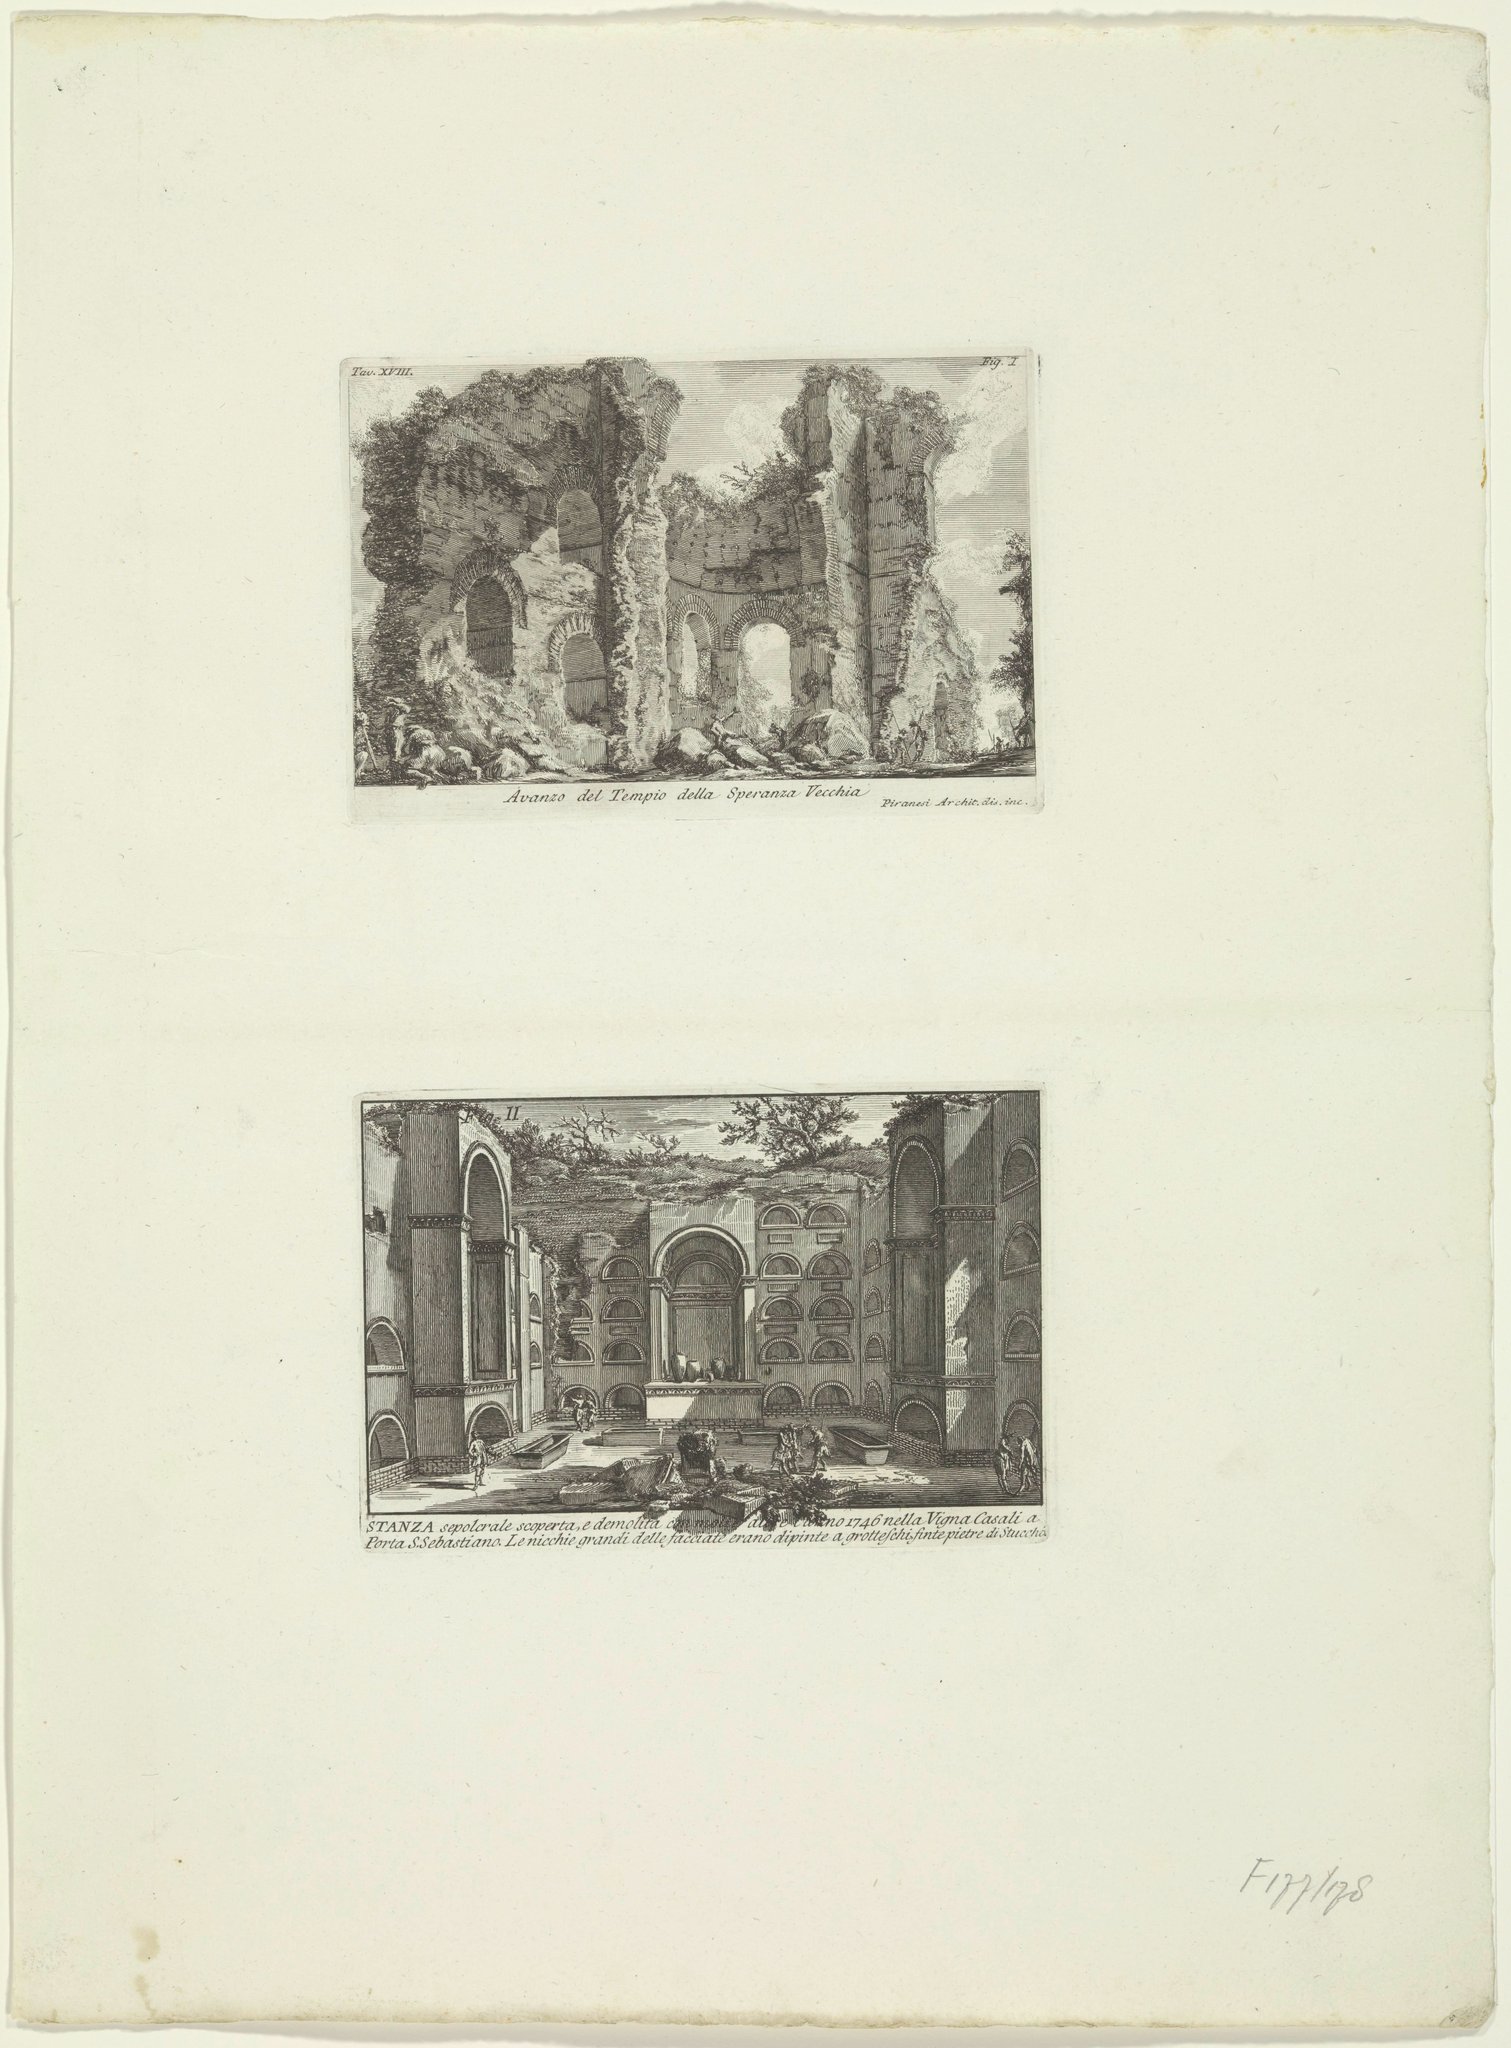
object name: print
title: Archeologische vondsten in en rond Rome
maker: giovanni battista piranesi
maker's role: designer, draughtsman, print maker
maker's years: 1720-1778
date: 1756-1757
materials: paper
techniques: etching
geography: rome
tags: ruin of a building ~ architecture, grave, tomb, temple, shrine ~ roman religion, italy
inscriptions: collector's mark: Lugt 2228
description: Blad met twee voorstellingen. Boven: de restanten van een tempel, volgens de titel de Tempio della Speranza Vecchia. Genummerd linksboven: Tav. XVIII. Genummerd rechtsboven: Fig. I. Titel in ondermarge. Onder: blik in een graftombe, volgens de titel gelegen bij Vigna Casali nabij de Porta San Sebastiano. Genummerd linksboven: Fig. II. Titel in ondermarge.